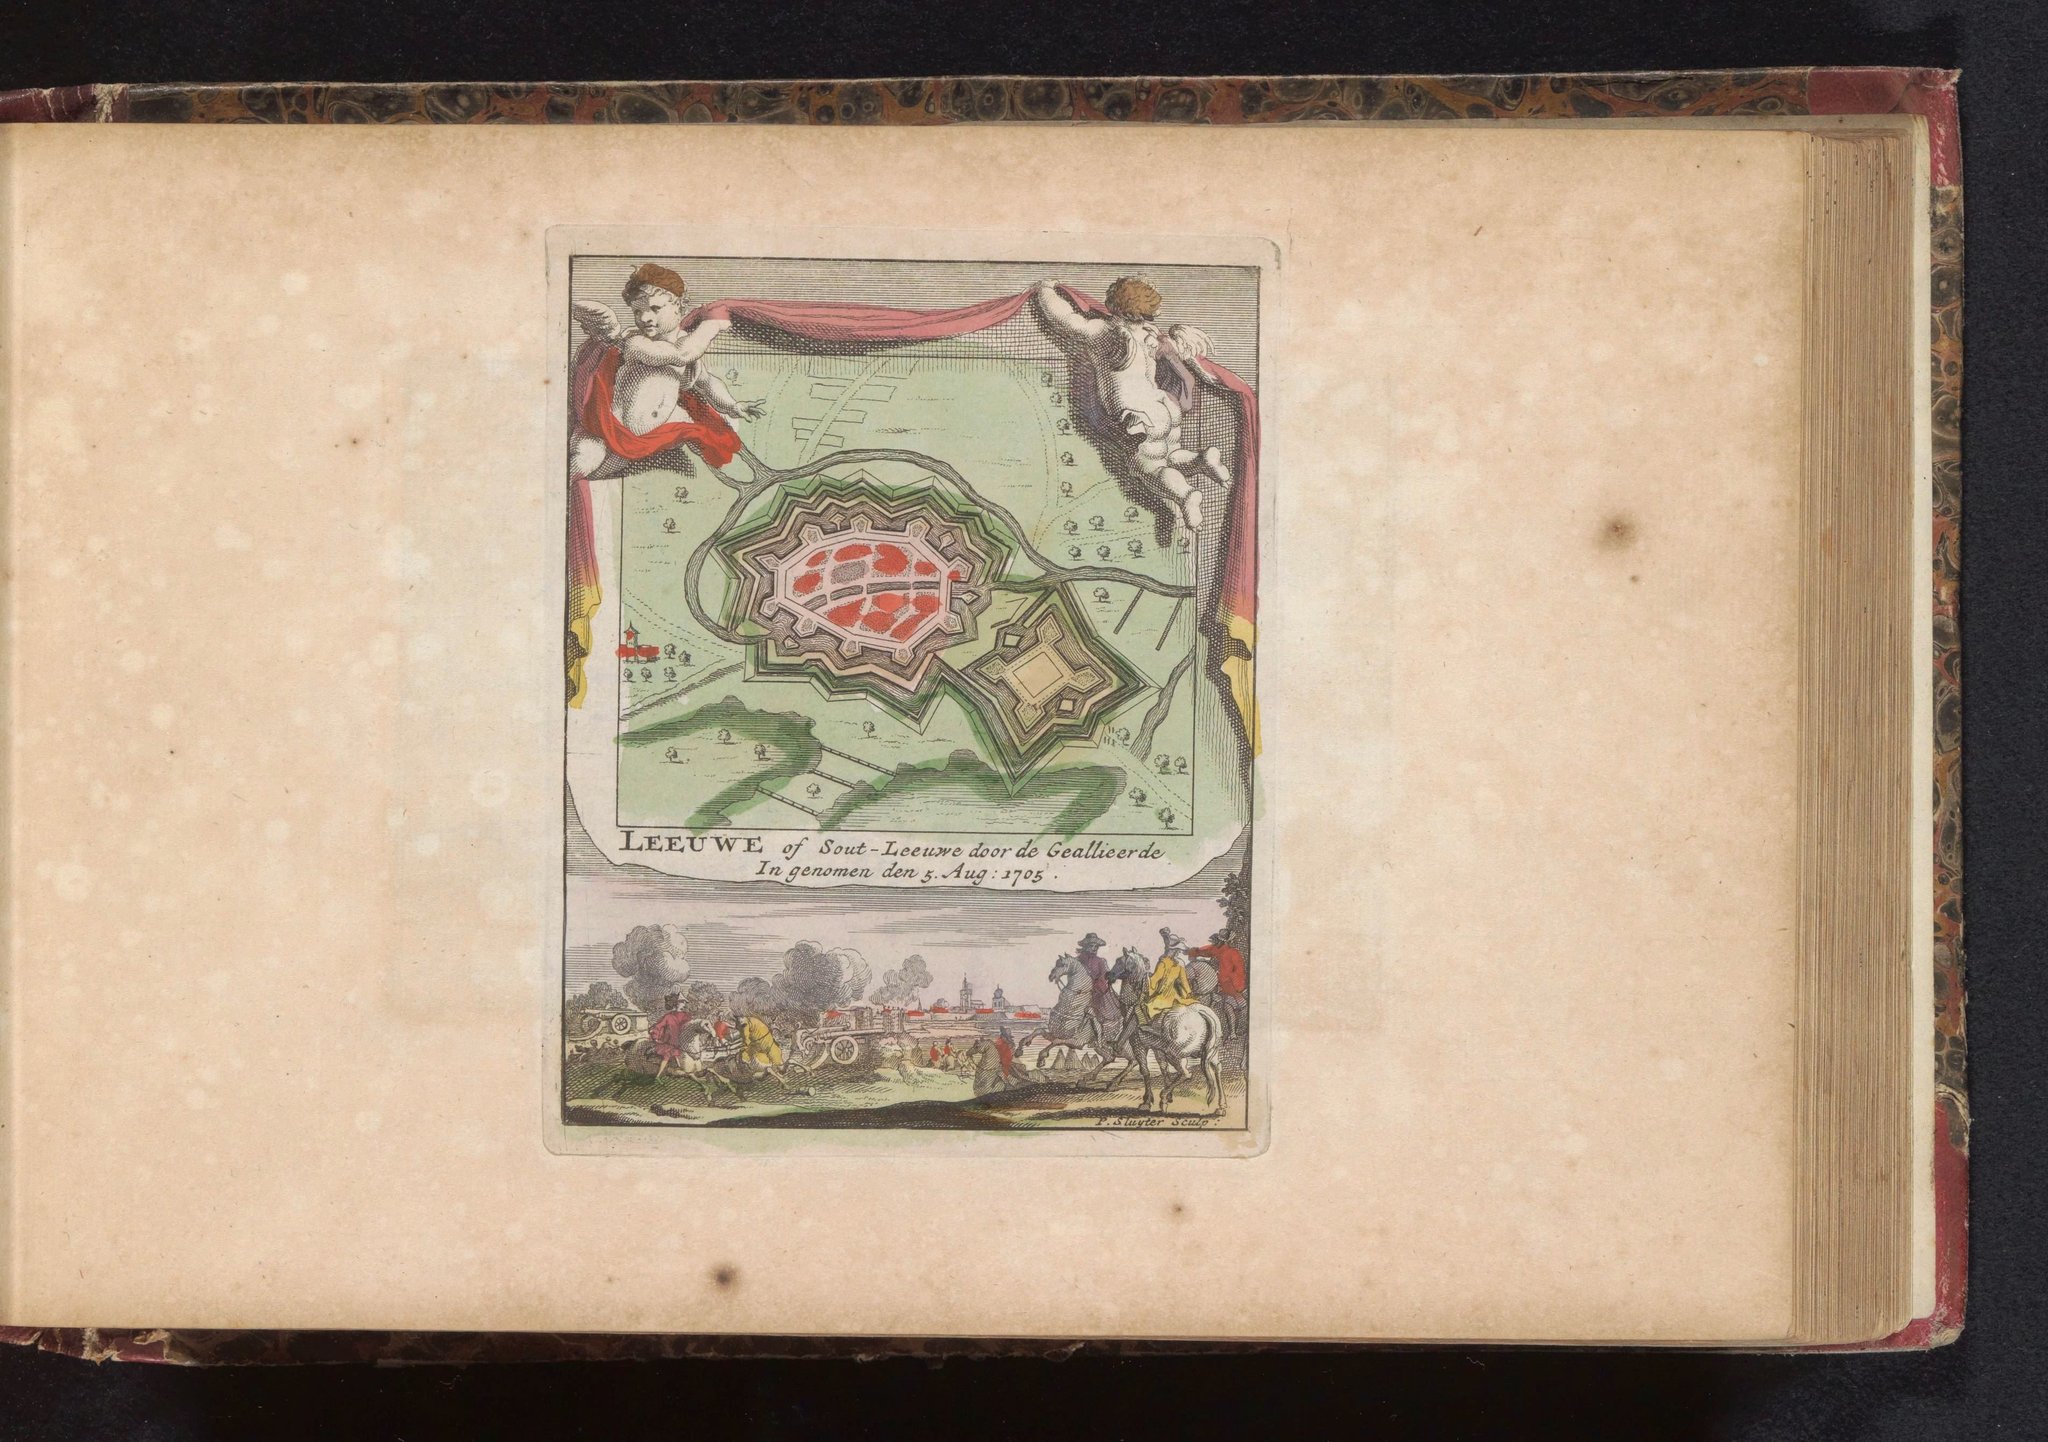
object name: map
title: Leeuwe of Sout-Leeuwe door de Geallieerde In genomen den 5. Aug: 1705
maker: zacharias chatelain (ii)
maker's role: bookseller, publisher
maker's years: 1690-1754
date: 1735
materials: paper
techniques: engraving, etching, hand coloring, lacquer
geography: amsterdam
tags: siege, position war, maps of cities, zoutleeuw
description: Verovering van Zoutleeuw (Leeuwe) door de Geallieerden op de Fransen, 5 augustus 1705. Bovenaan een plattegrond van de versterkingen om de stad, onderaan een gezicht van de strijd. Onderdeel van een atlas met 223 kaarten van landen en steden en oorlogstaferelen in Europa in de periode ca. 1690-1735.